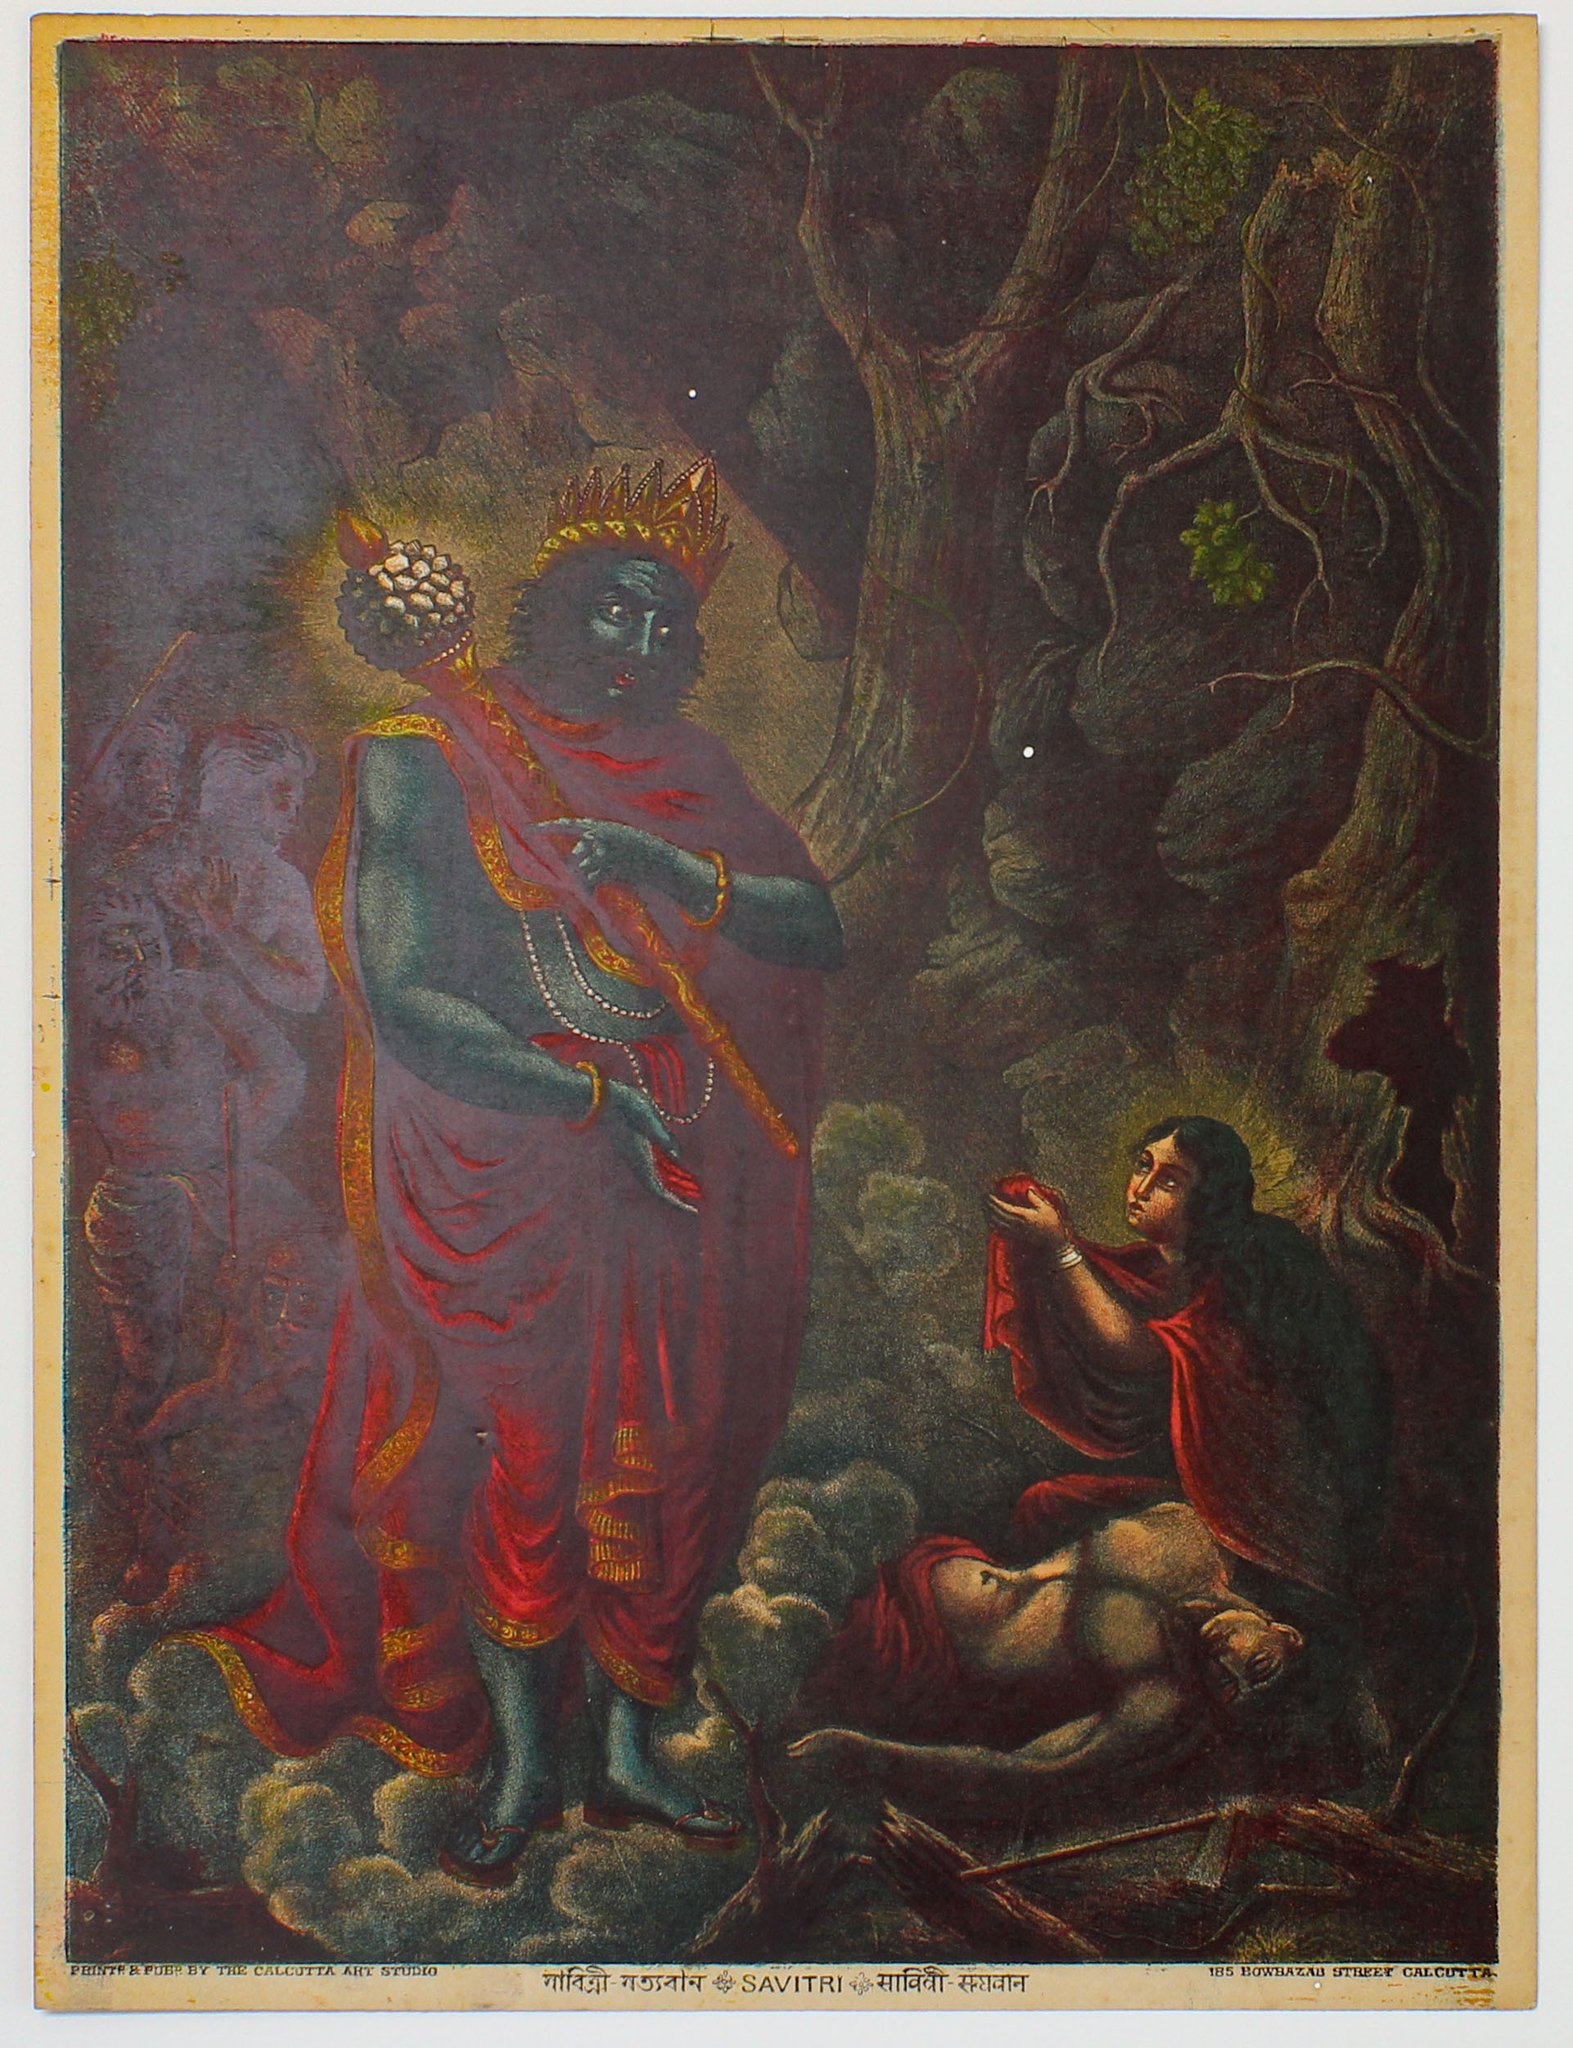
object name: print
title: Savitri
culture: indian or west bengali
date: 1885-1890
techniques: lithograph